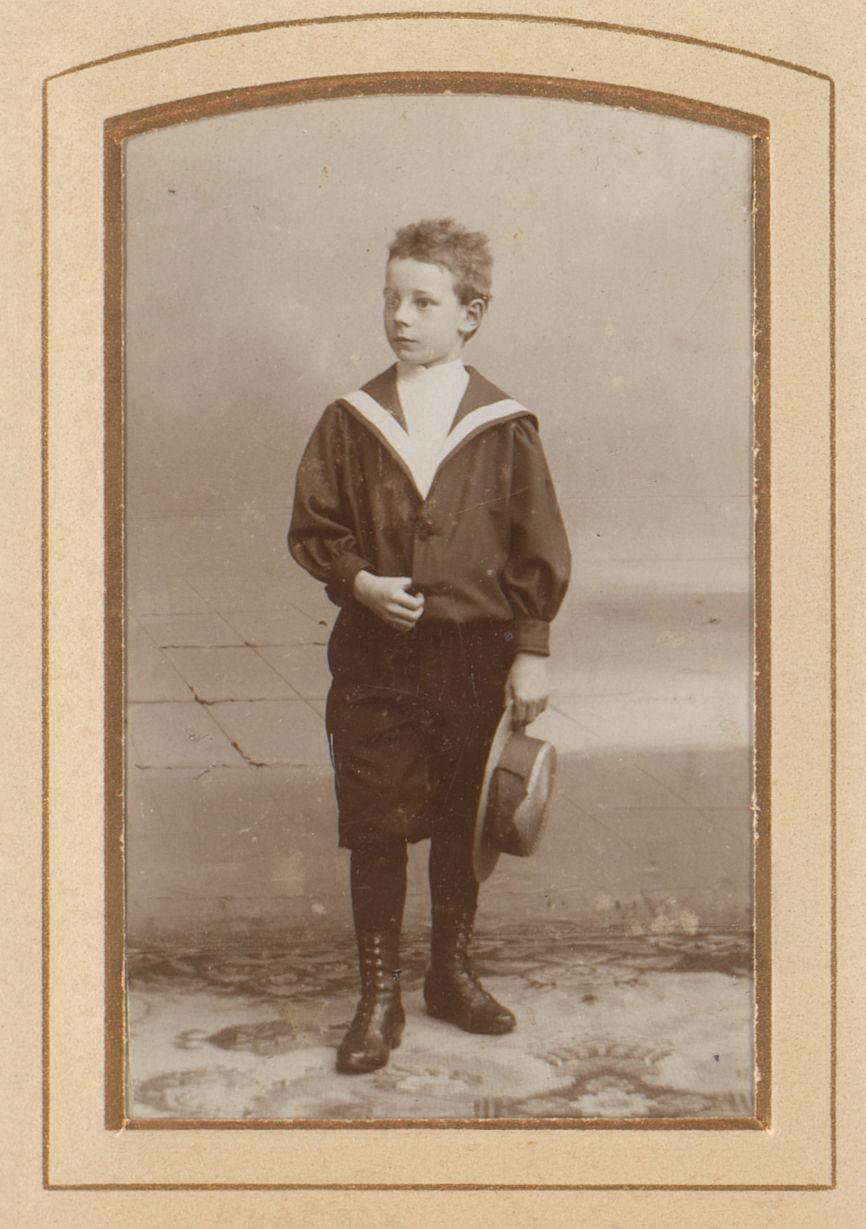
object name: photograph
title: Portret van een jongen met hoed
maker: Anonymous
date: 1890-1920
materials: cardboard, photographic support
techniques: collodion silver print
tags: boy (child between toddler and youth), head-gear: hat